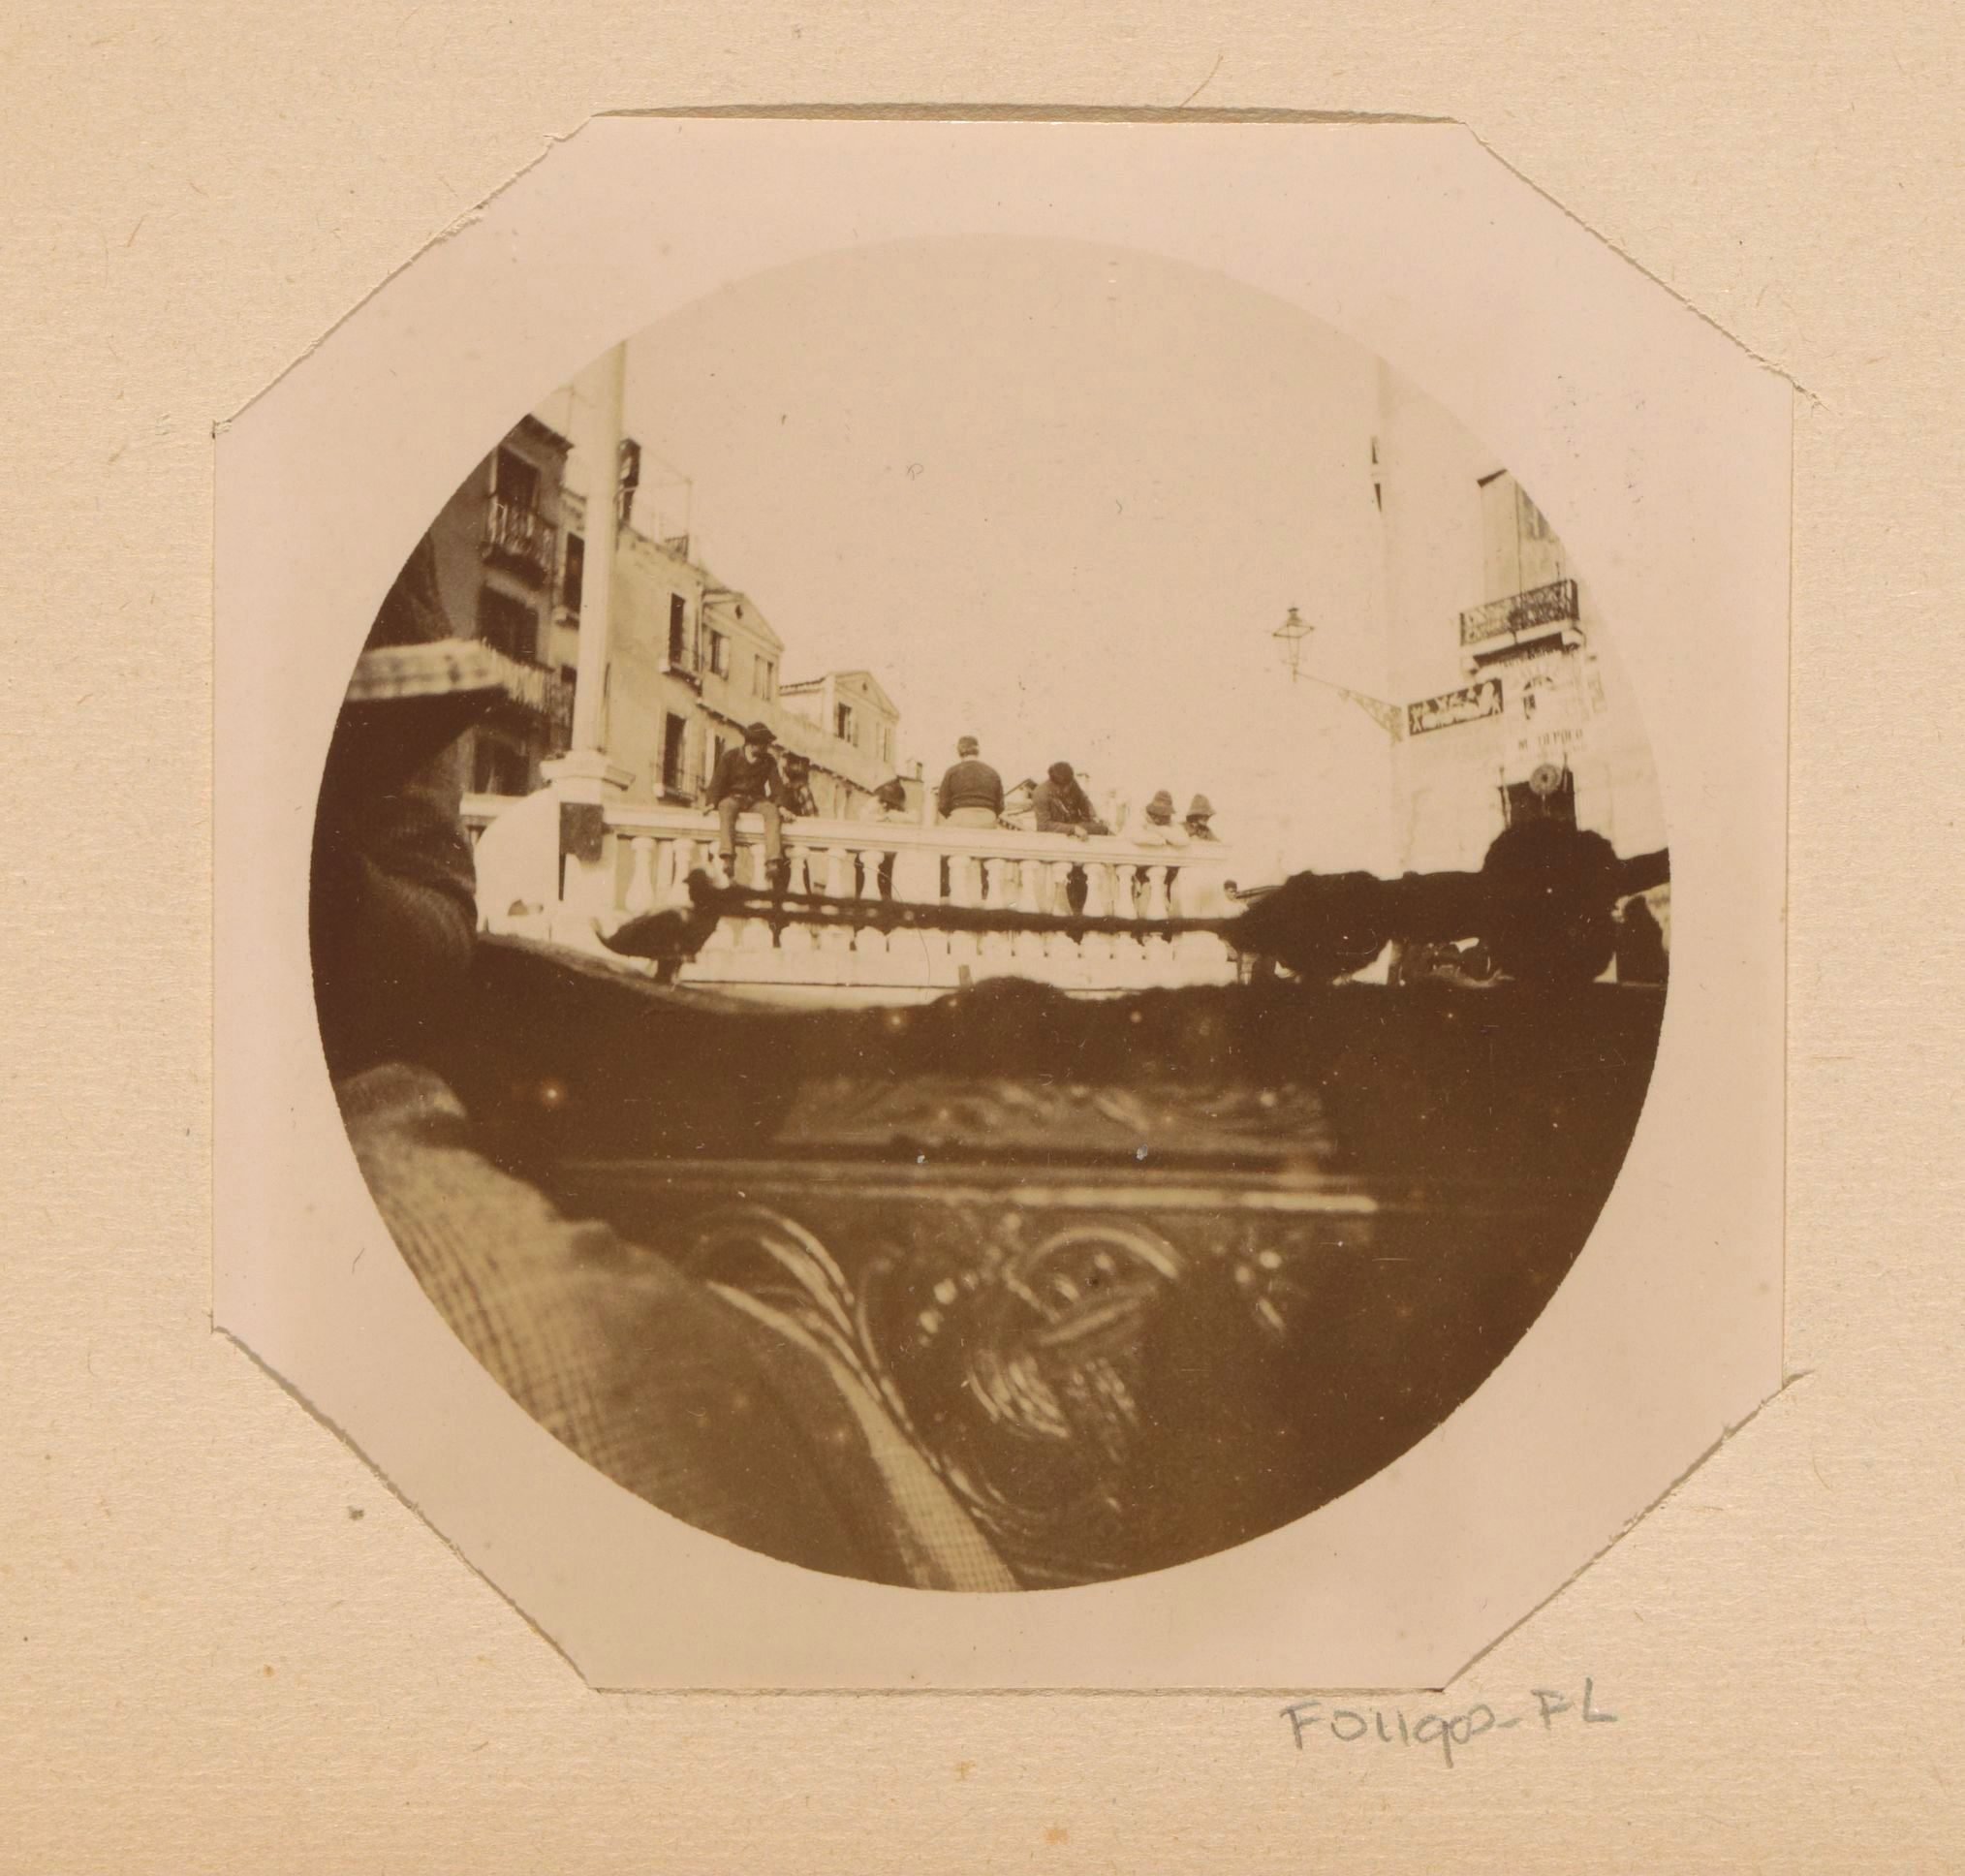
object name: album leaf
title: Uitzicht op een brug in Venetië vanuit een gondel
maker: johanna margaretha piek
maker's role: fotograaf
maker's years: 1870-1947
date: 1889-1893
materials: paper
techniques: gelatin silver print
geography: venice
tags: bridge in city across river, canal, etc., gondola, venice